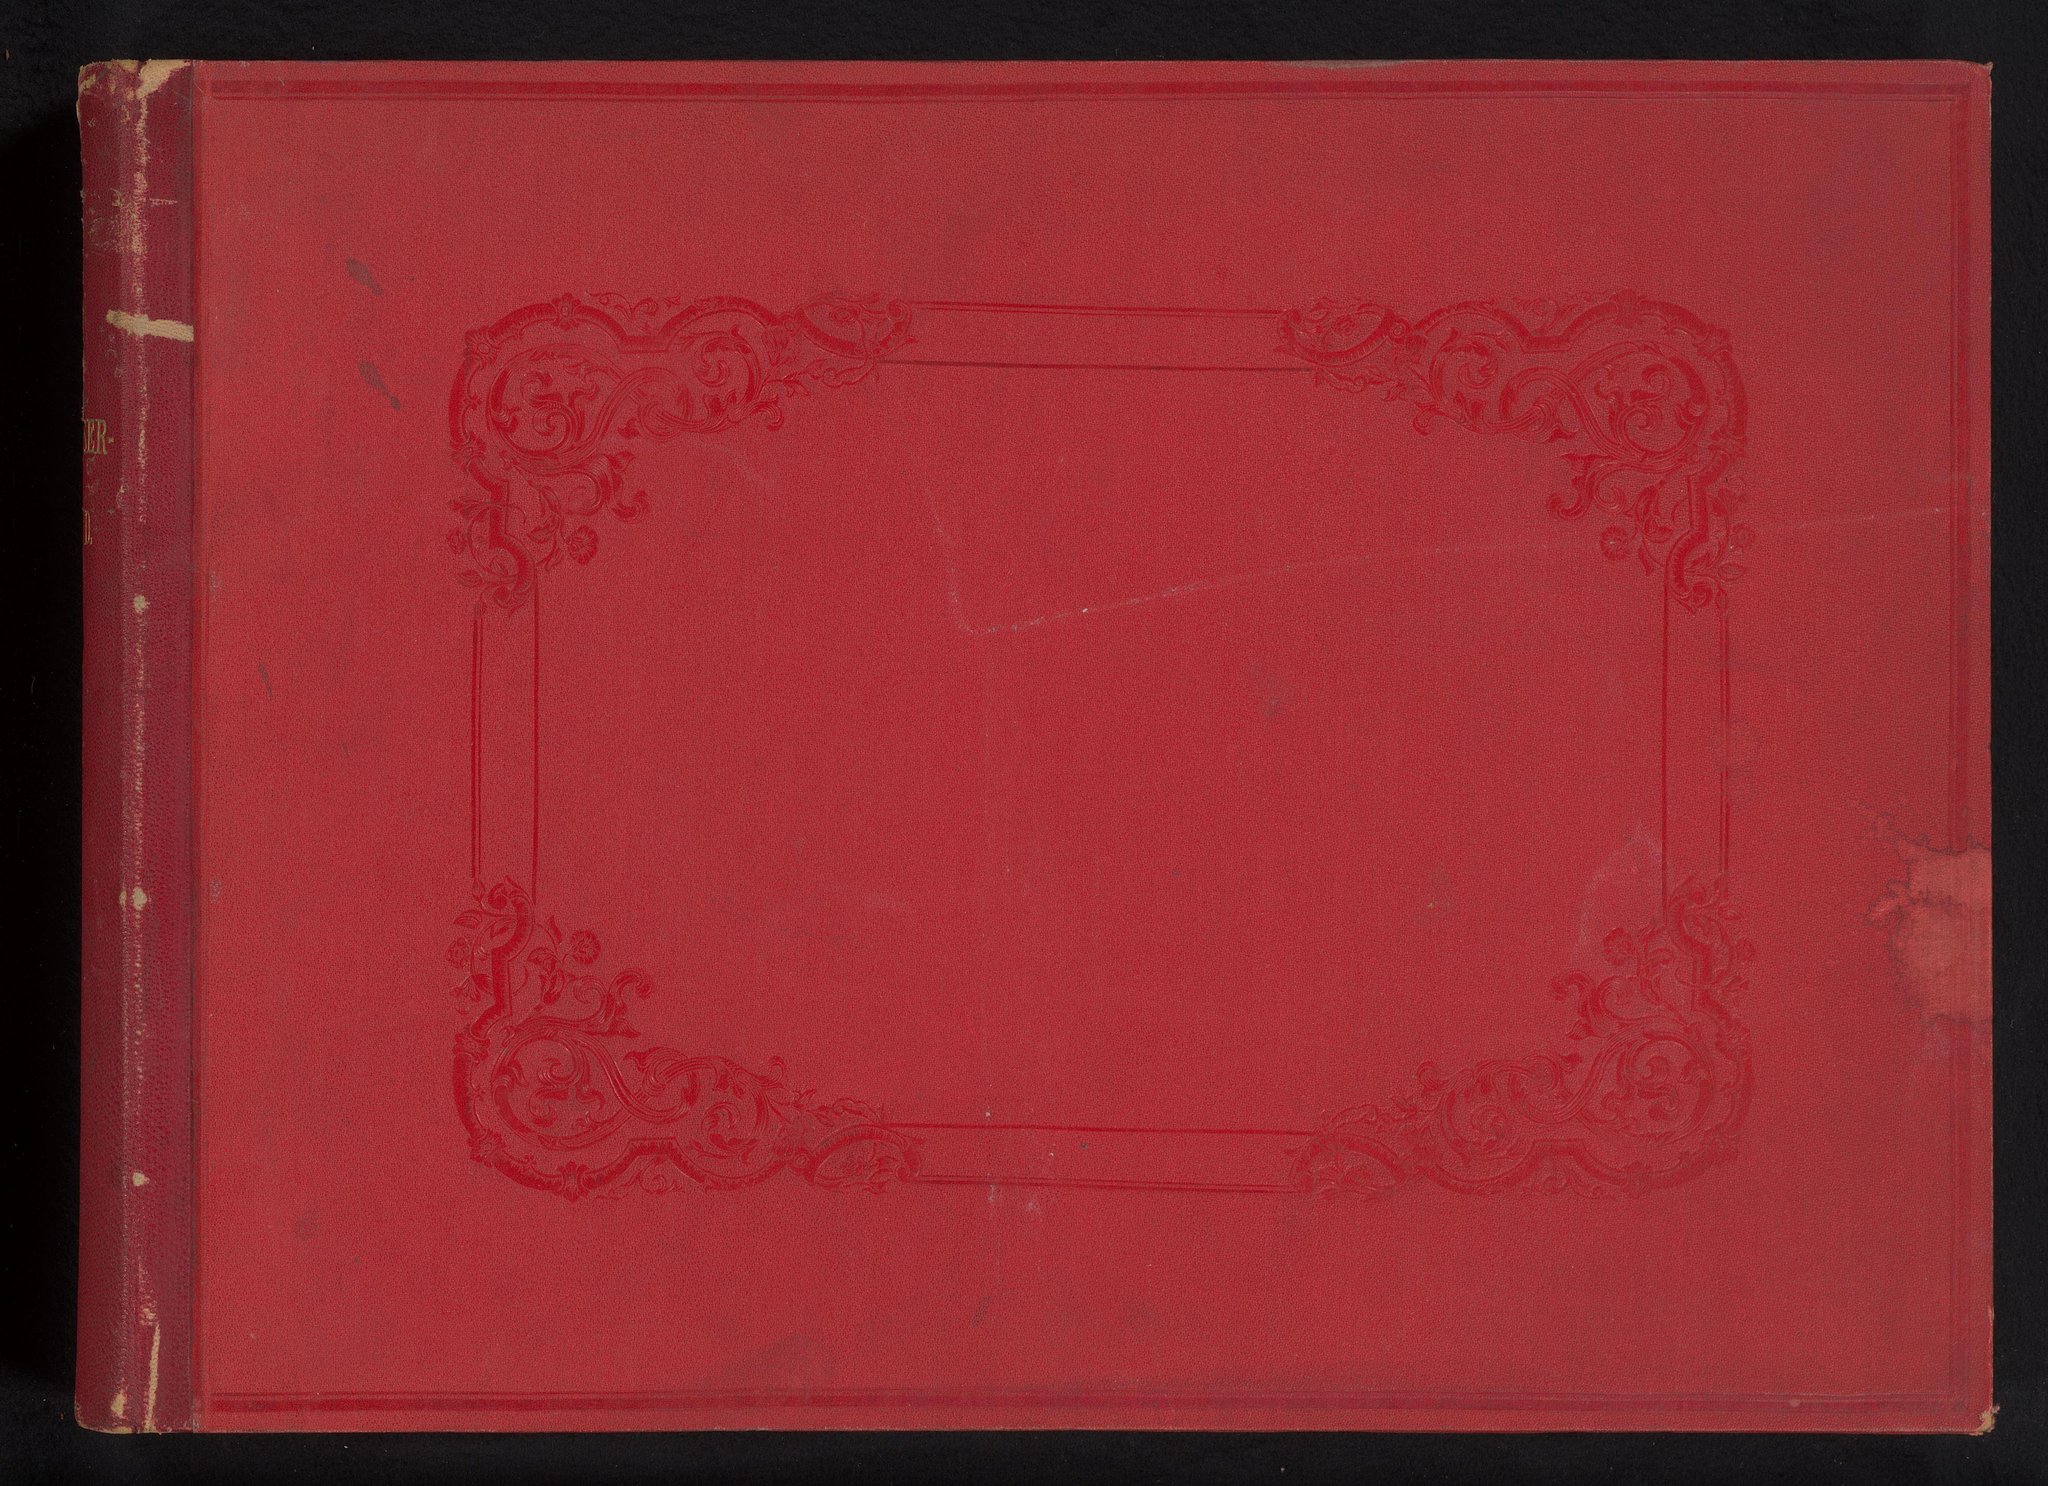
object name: scrapbook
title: Topografisch fotoalbum met 69 foto's en 5 prenten van Zwitserland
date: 1880-1900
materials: cardboard, leather, paper, photographic support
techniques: albumen print, photograph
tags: city-view in general; 'veduta', landscapes in the temperate zone, waterfall, meadow, pasture, ravine, chasm, abyss, canyon, church (exterior), lake, monument, statue, glacier, mountain-range, snow peaks, street (+ city(-scape) with figures, staffage), mountains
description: Fotoalbum met 144 bladen met in totaal 69 foto's en 5 prenten. Het zijn topografische foto's van Zwitserland van rond het einde van de negentiende eeuw. Onder andere te zien zijn de Alpen, Brienz, Lauterbrunnen, Bazel, Bern en de omgeving van het Vierwoudstrekenmeer. Het album bevat ook 5 staalgravures en een uitvouwbare panoramafoto.